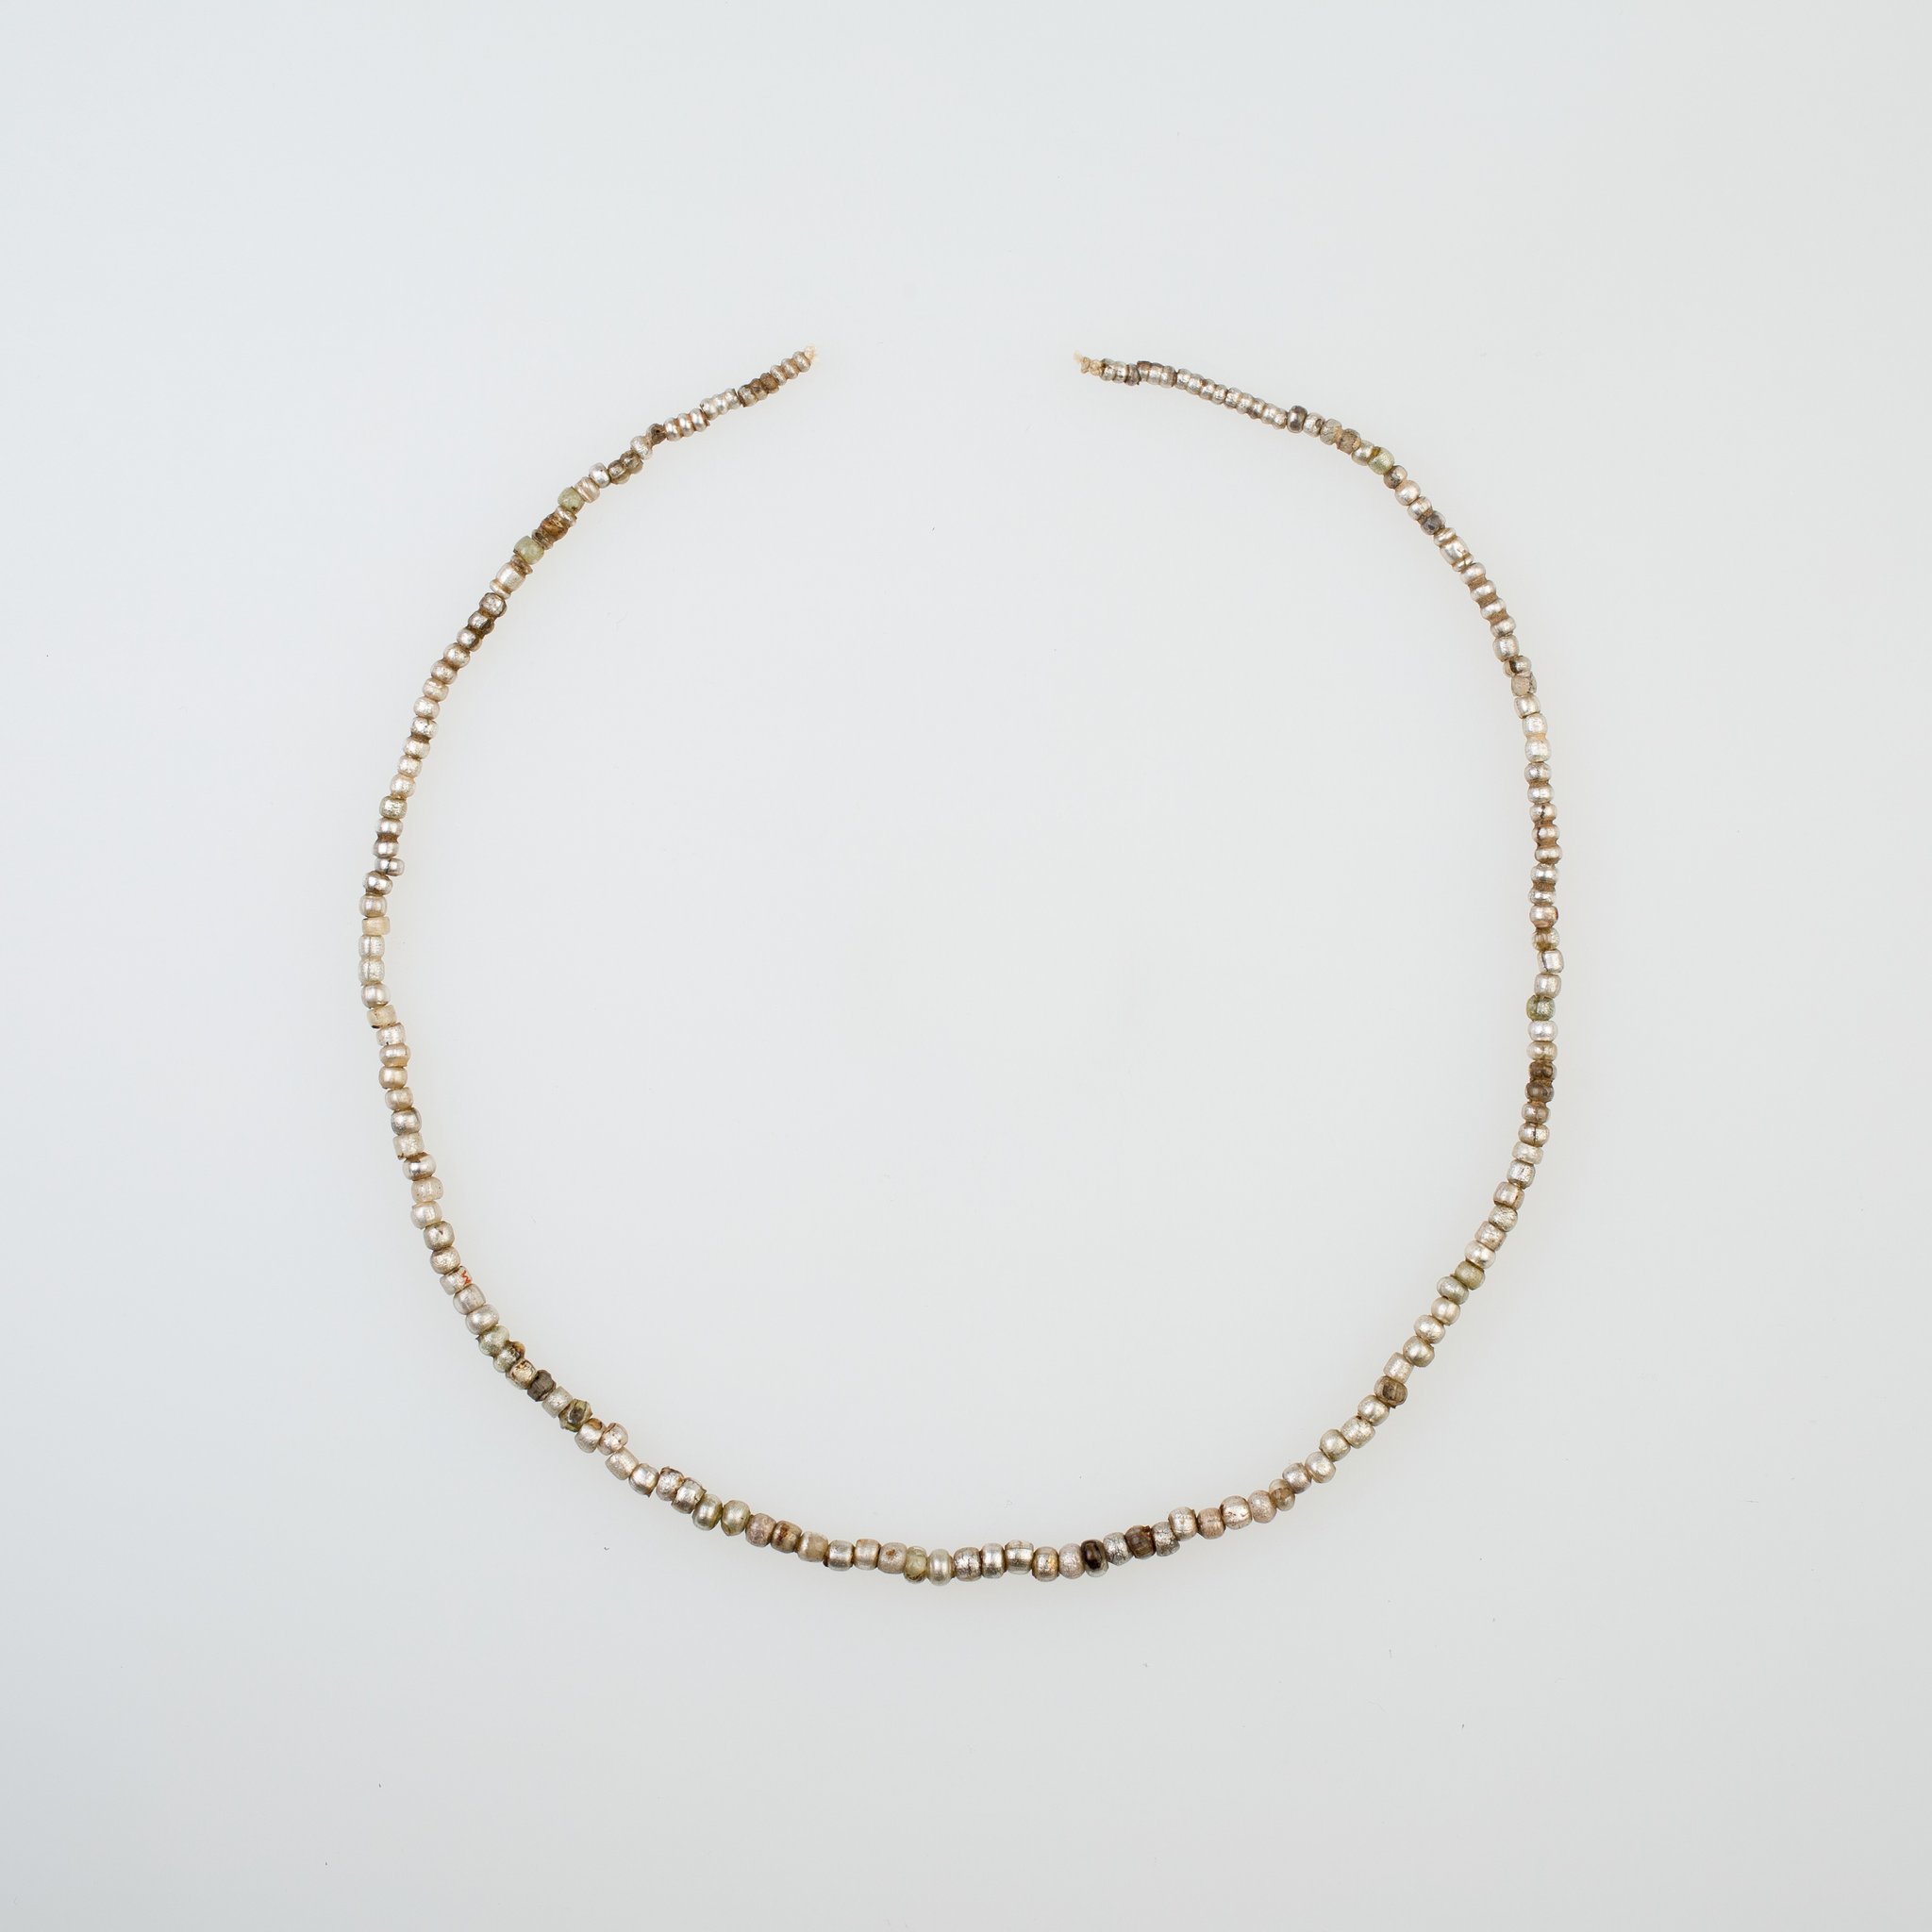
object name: bead, string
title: String of Beads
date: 200 BCE-200 CE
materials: glass, gold foil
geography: egypt